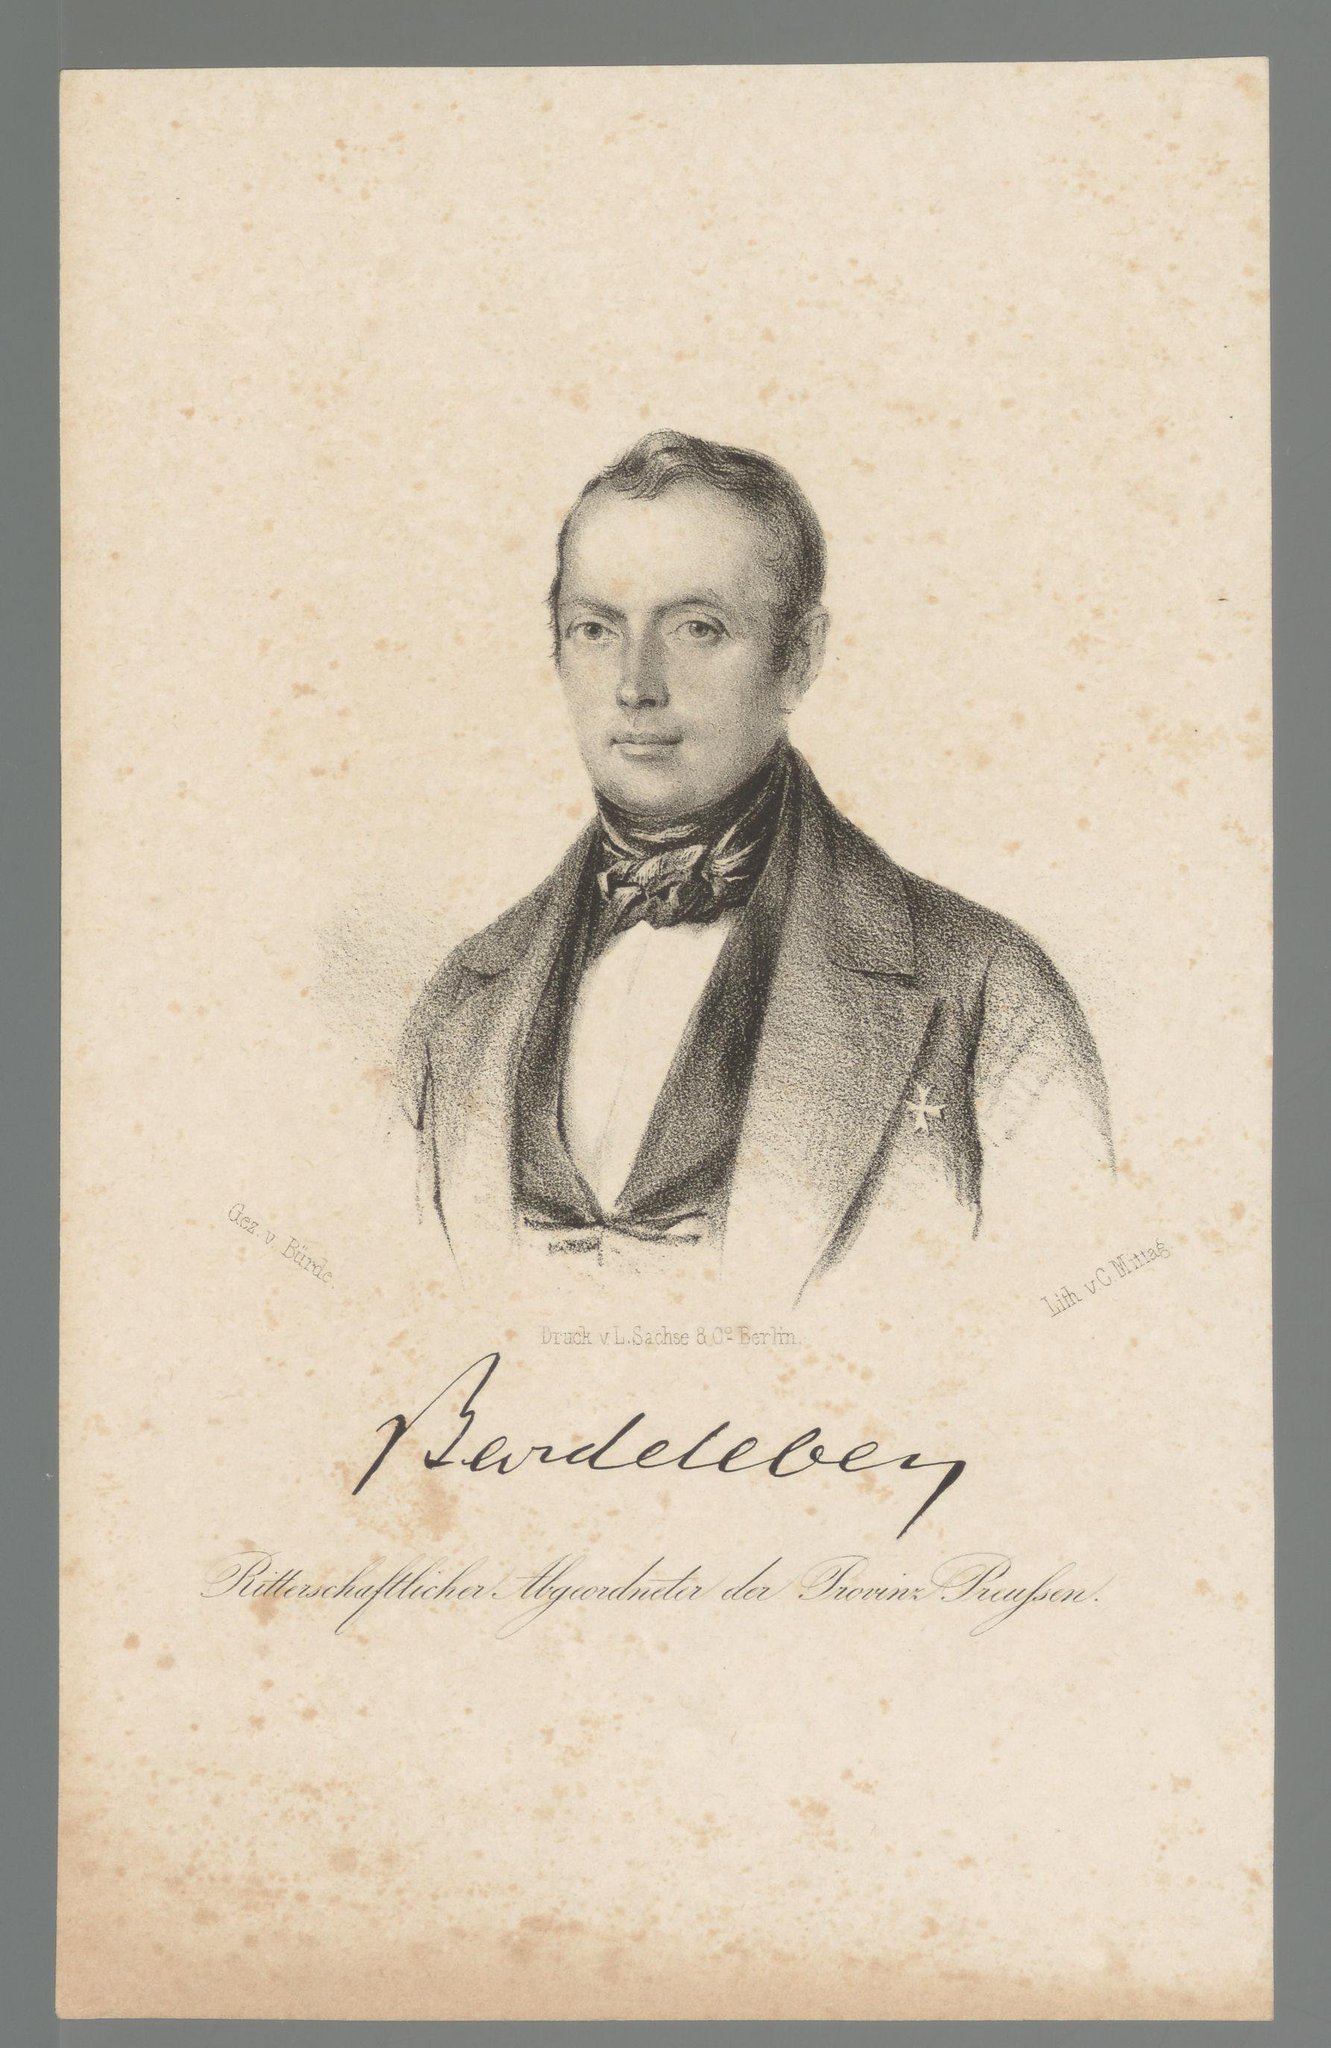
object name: print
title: Portret van Moritz Bardeleben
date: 1832-1854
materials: paper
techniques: lithograph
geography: berlin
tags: berlin, adult man, historical persons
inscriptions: collector's mark: Lugt 2228